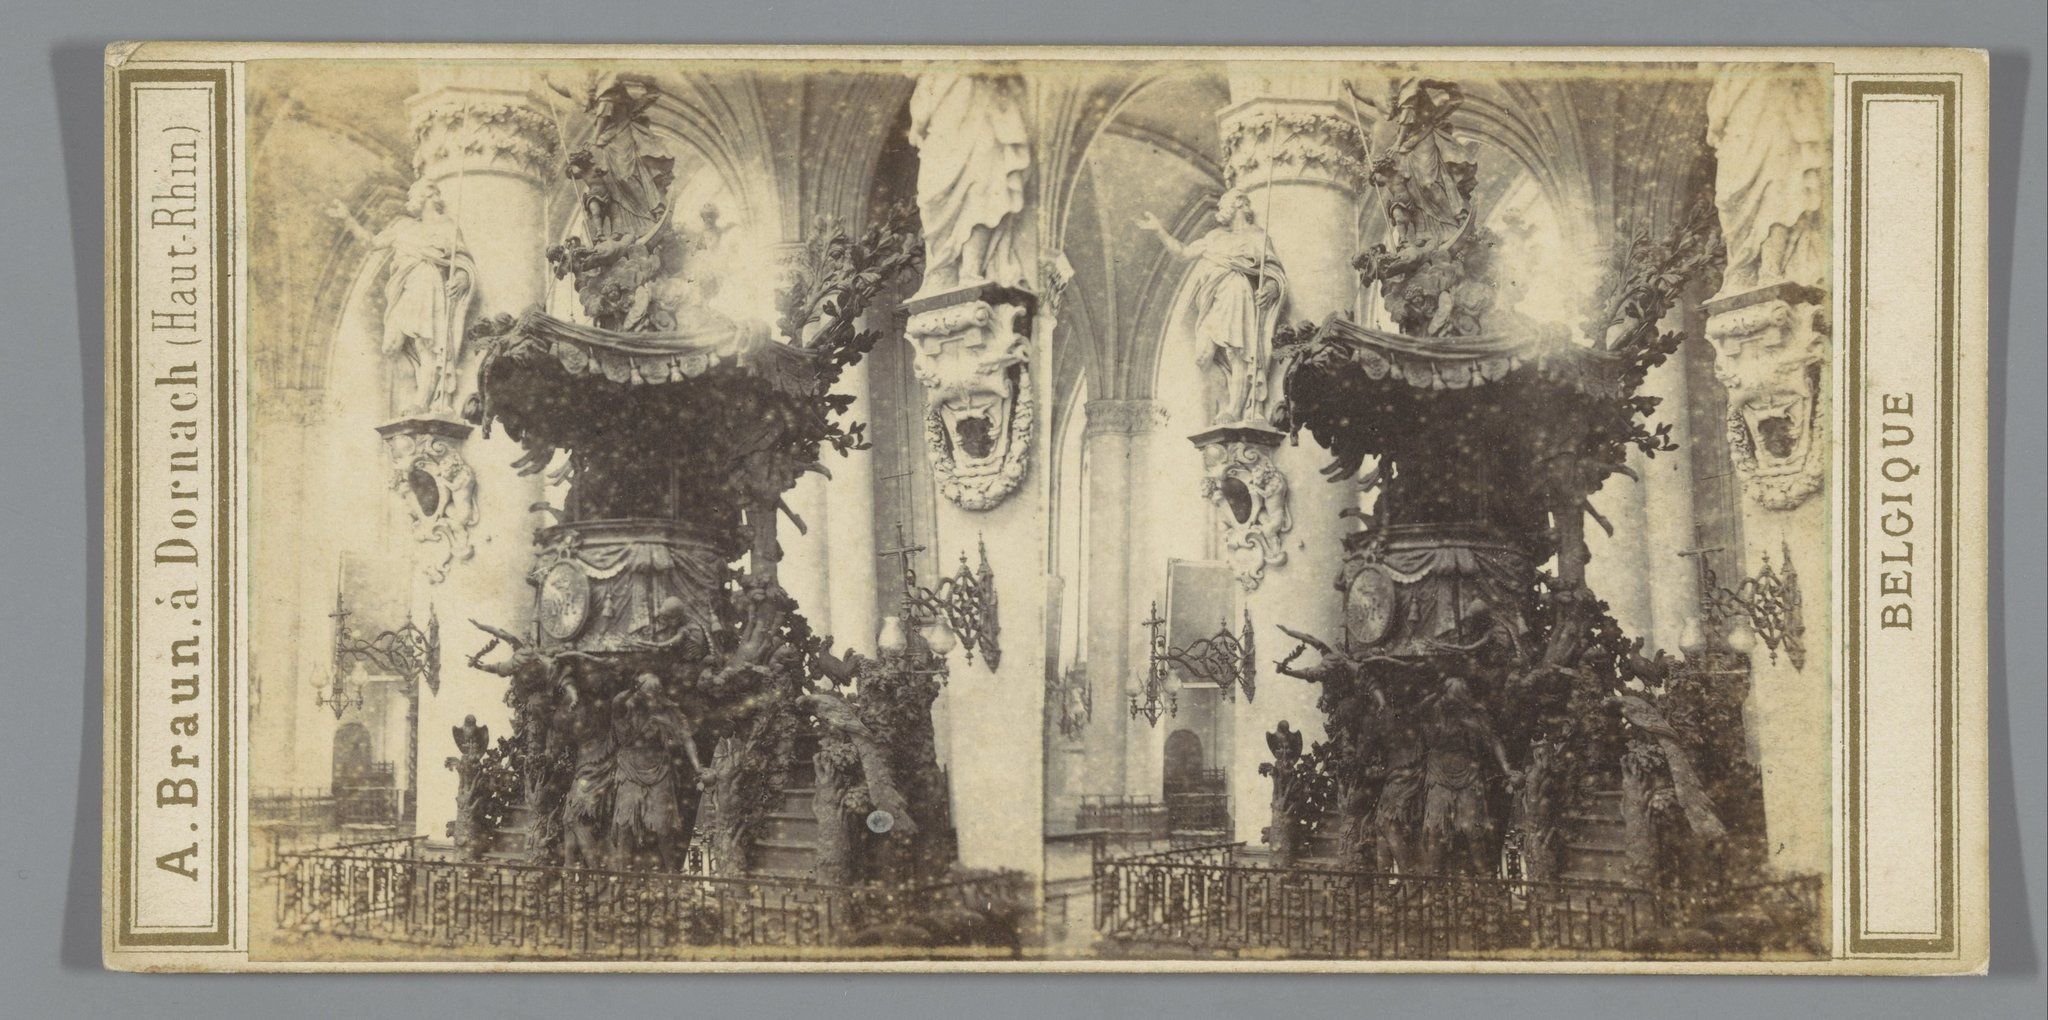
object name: stereograph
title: Preekstoel in de Kathedraal van Sint-Michiel en Sint-Goedele, Brussel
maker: Anonymous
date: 1860-1866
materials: cardboard, paper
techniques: albumen print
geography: dornach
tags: pulpit, ambo, chancel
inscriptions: number: ‘No 4031.’, inscription: ‘11/12 Sept 67’